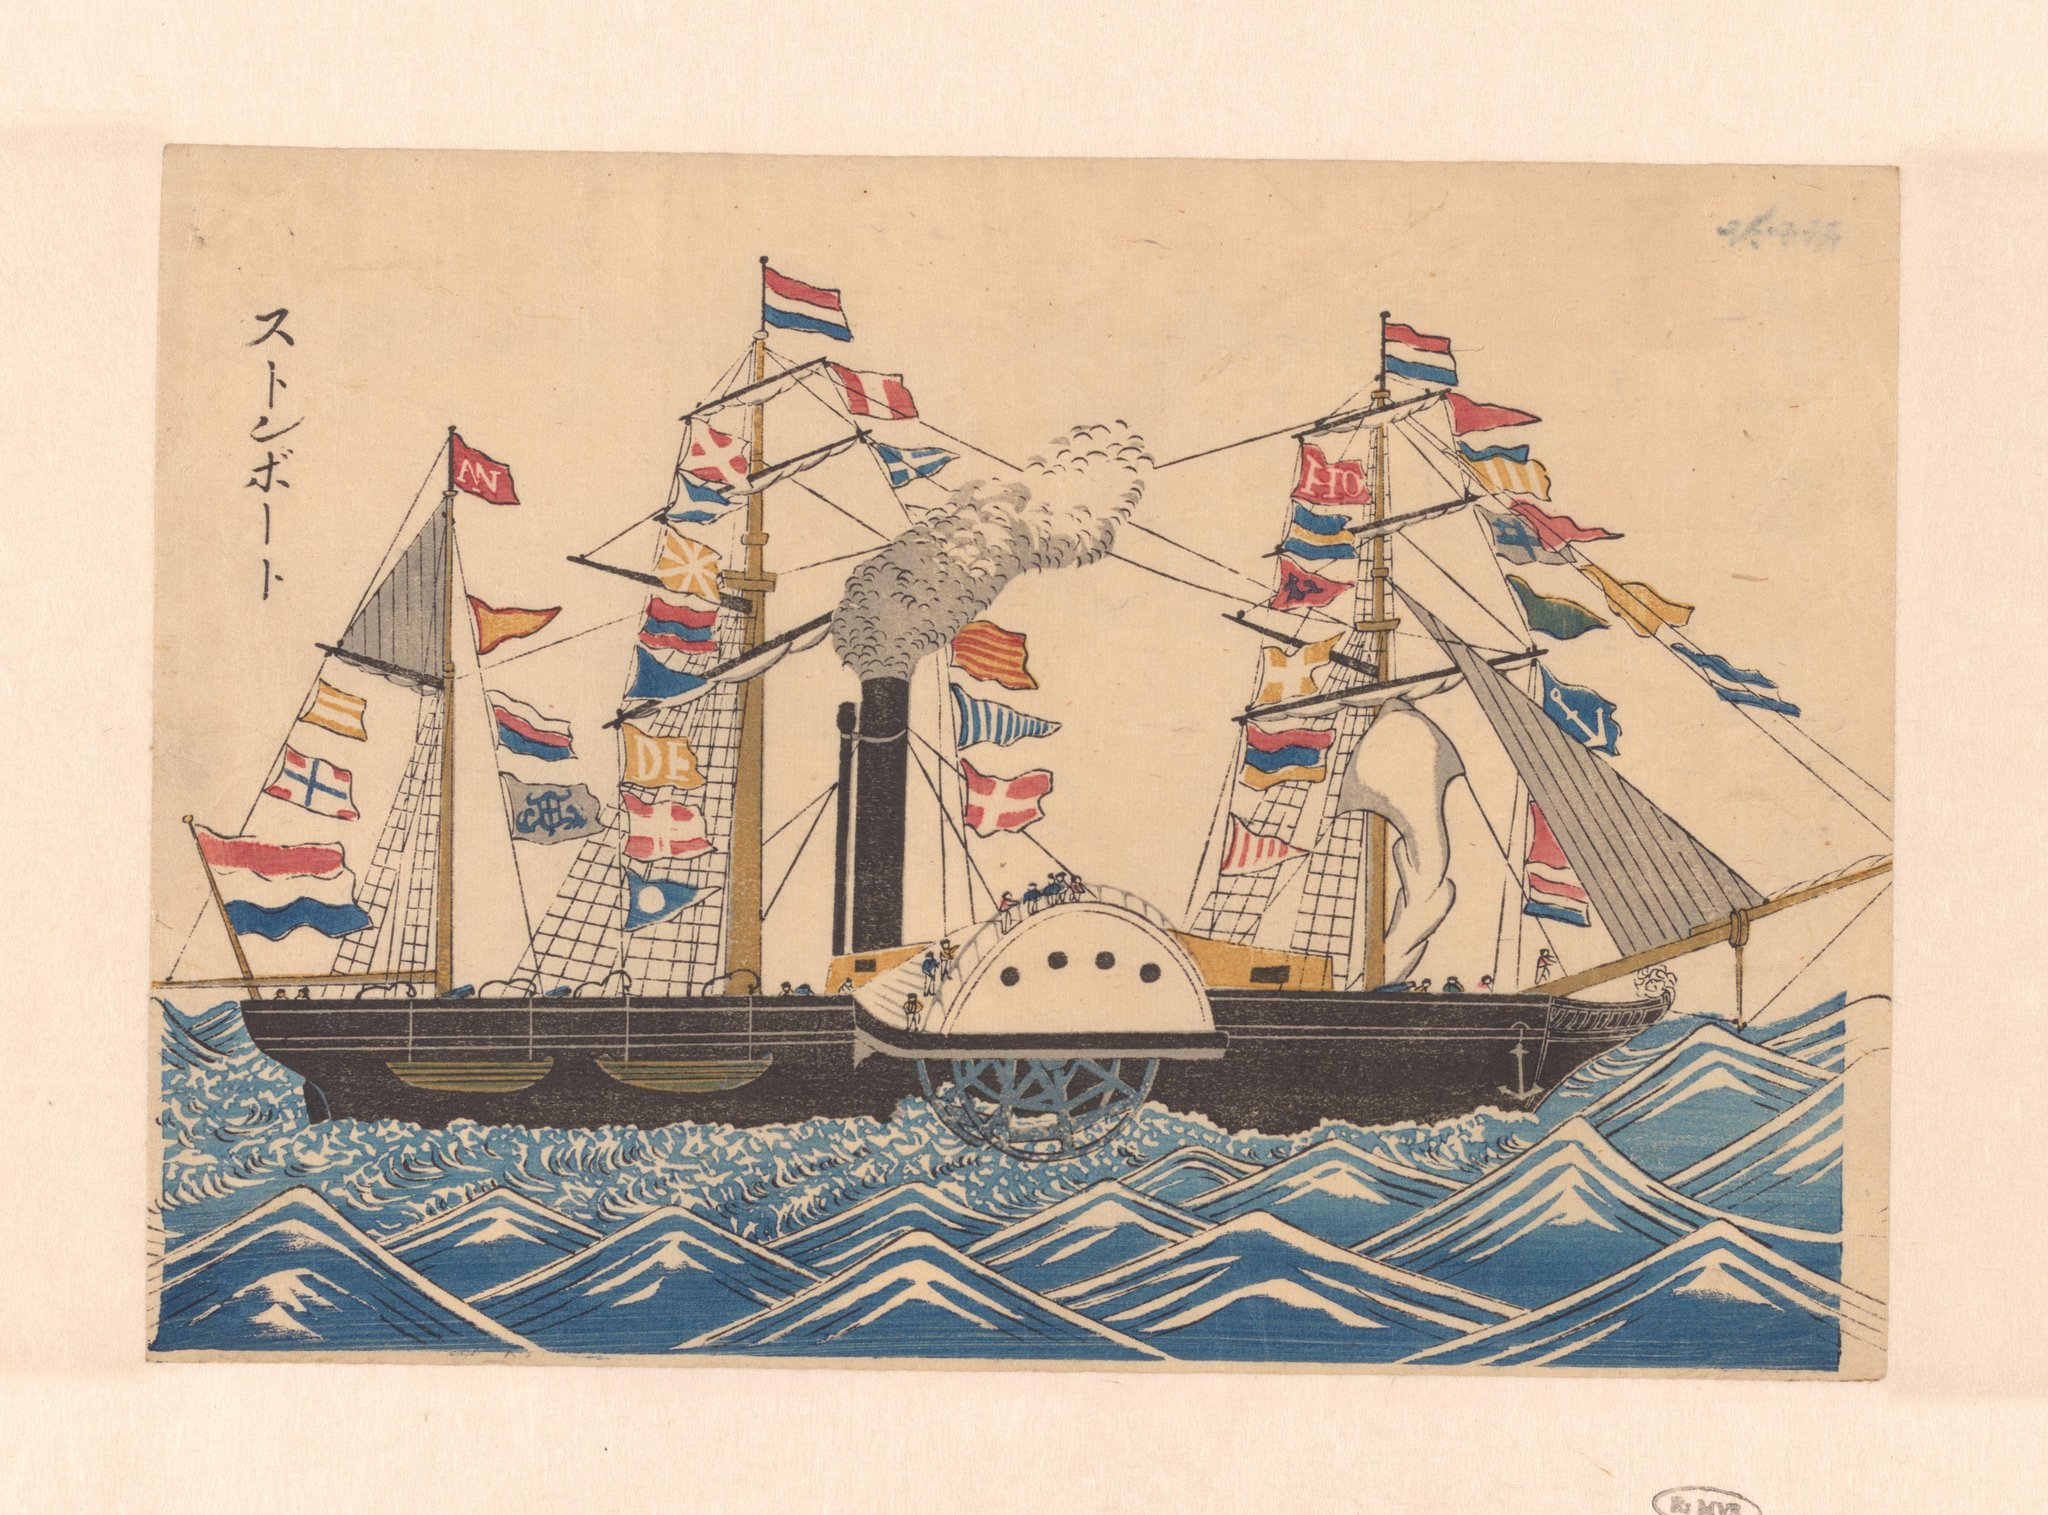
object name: print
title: Stoomboot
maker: Anonymous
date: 1850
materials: paper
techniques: woodcut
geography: japan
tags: flag, colours (as symbol of the state, etc.), paddle-wheel boat, japan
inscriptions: collector's mark: Lugt 2228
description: Stoomschip met drie masten, versierd met verschillende vlaggen, waaronder meedere Nederlandse vlaggen. Nagasaki-e